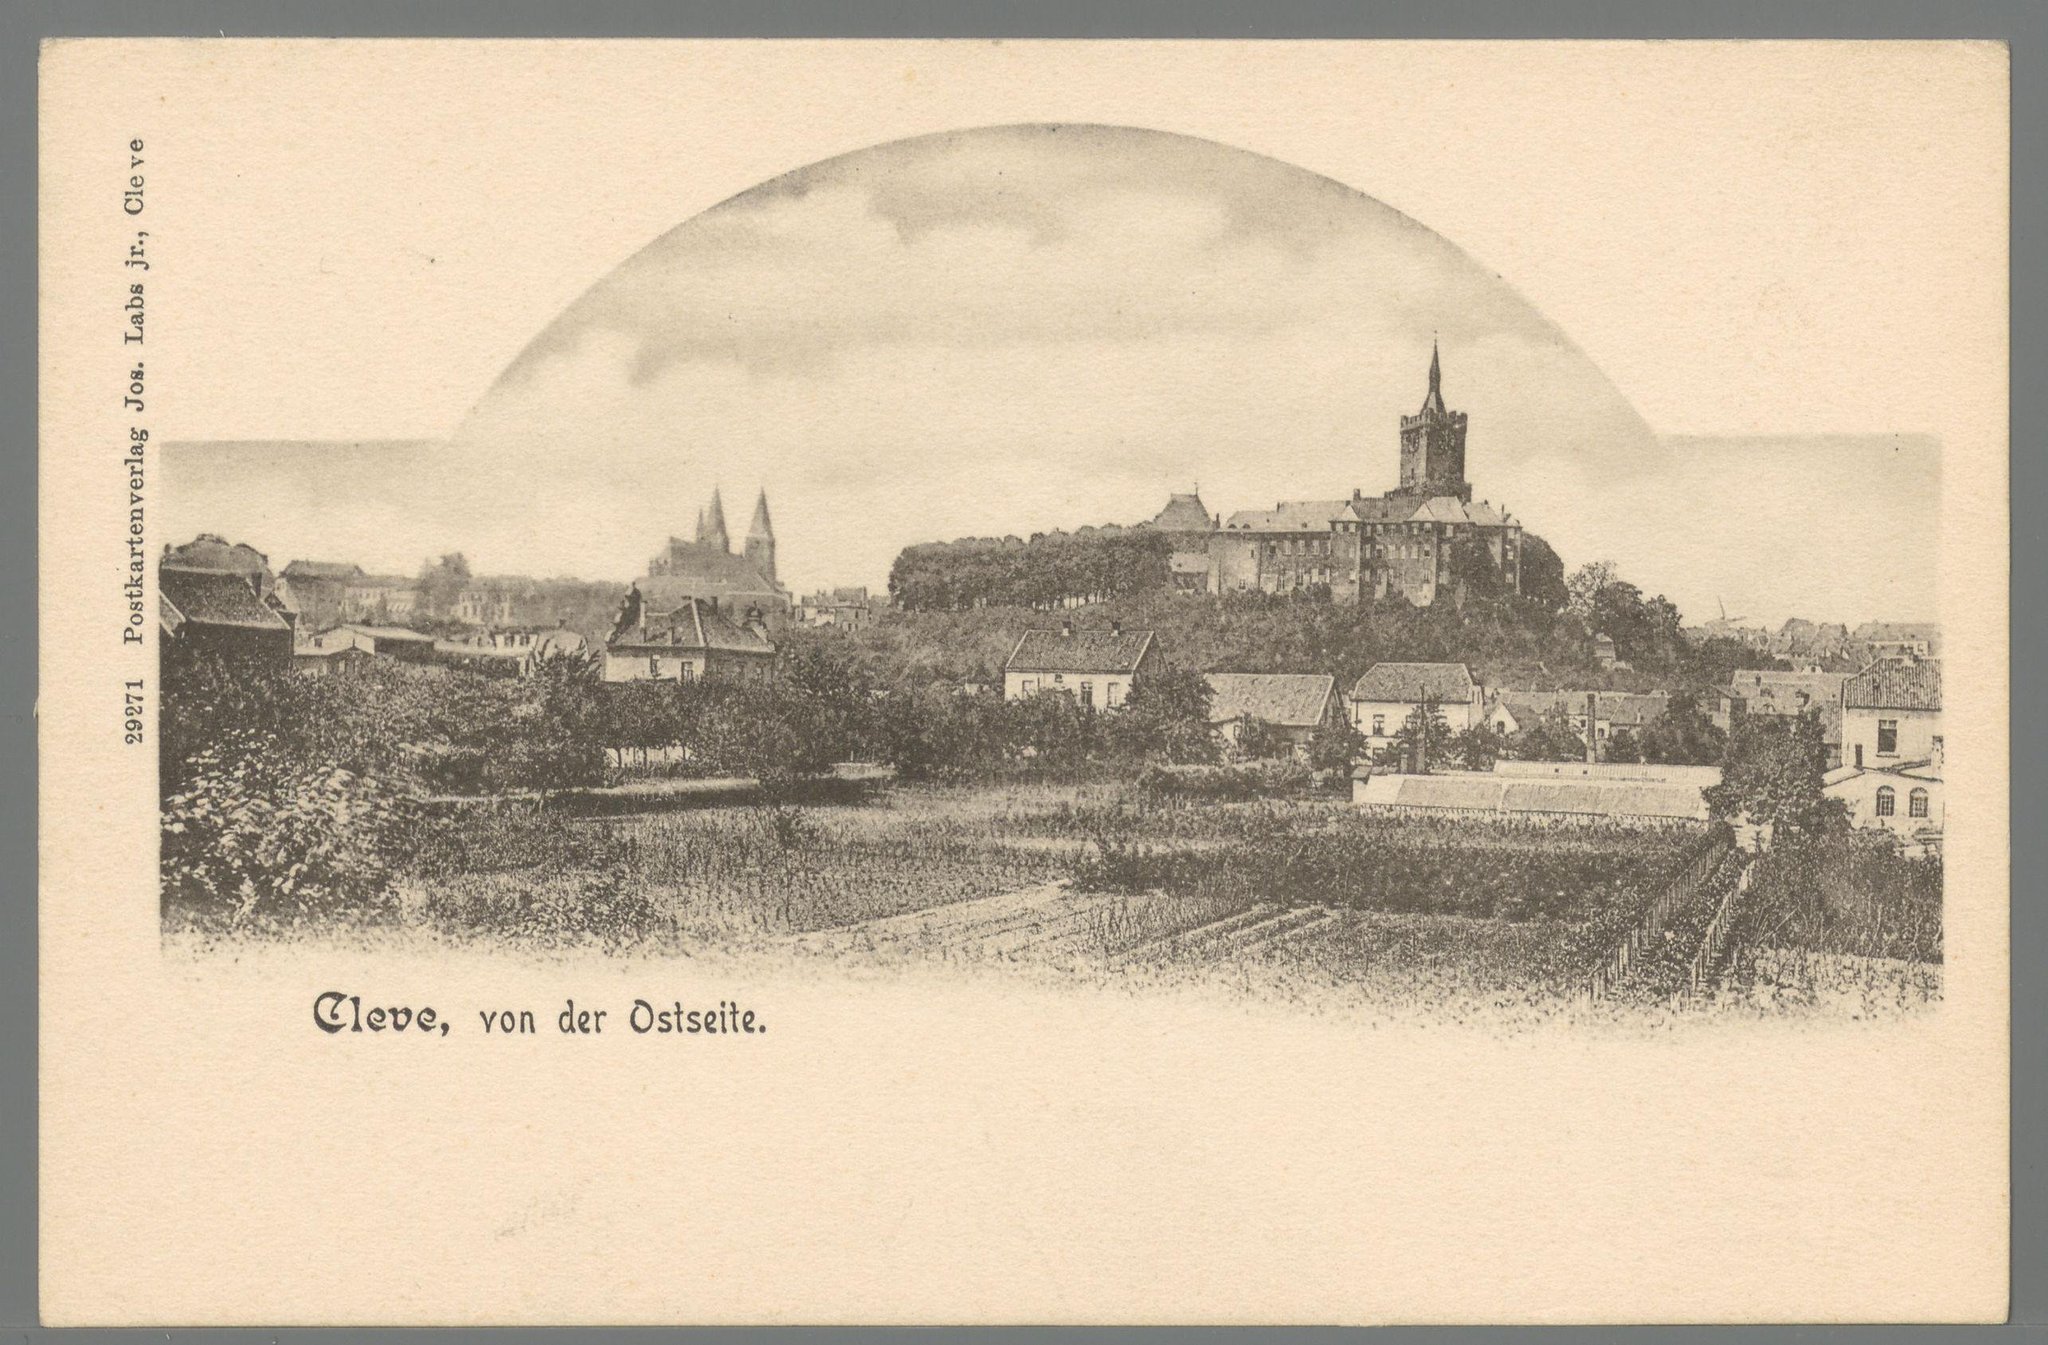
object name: ansichtkaart, prentbriefkaart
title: Cleve, von der Ostseite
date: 1885-1905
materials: cardboard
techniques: photograph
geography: cleves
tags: city-view, and landscape with man-made constructions, castle, cleves